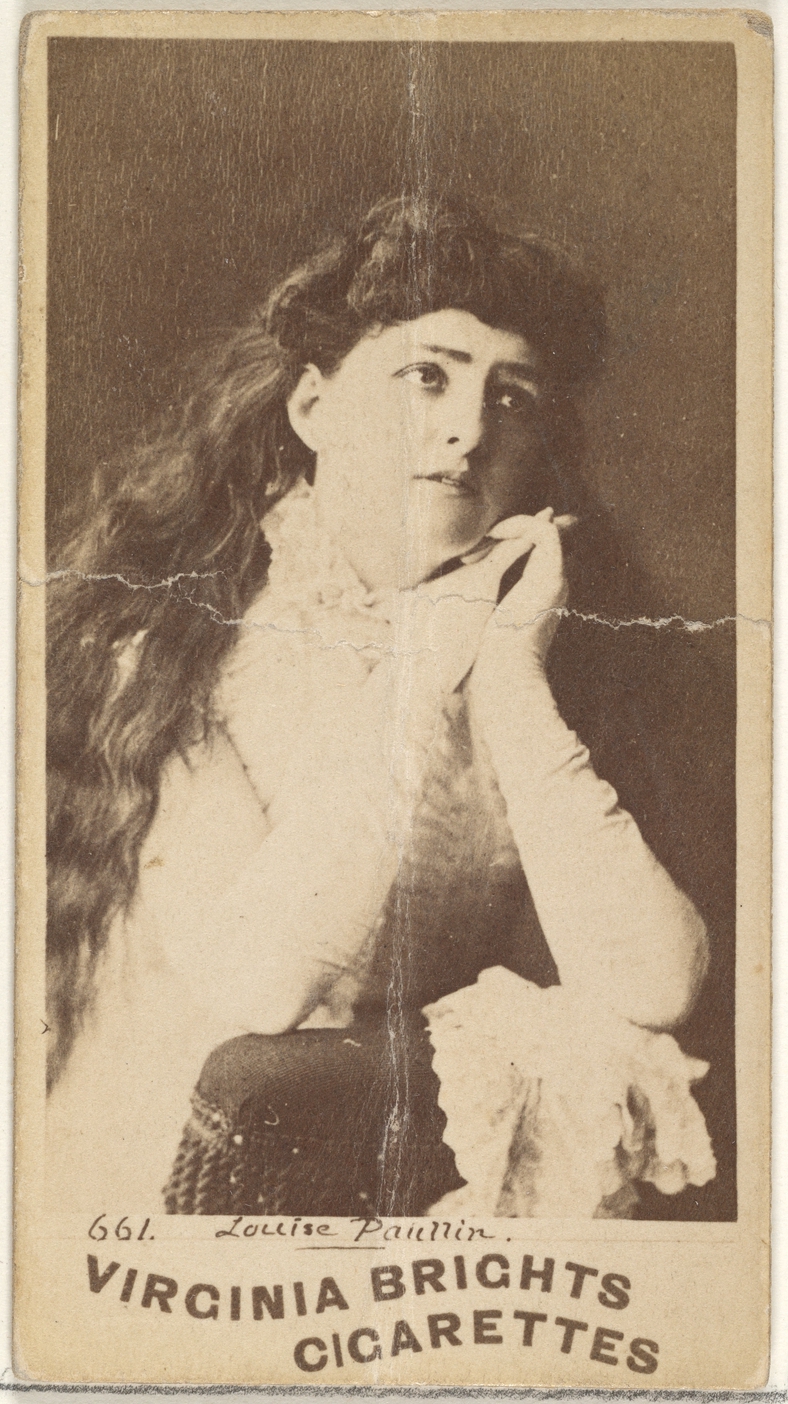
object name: photograph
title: Card 661, Louise Paullin, from the Actors and Actresses series (N45, Type 1) for Virginia Brights Cigarettes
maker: allen & ginter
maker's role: publisher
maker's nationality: american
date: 1888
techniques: albumen silver print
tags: portraits,women,actresses